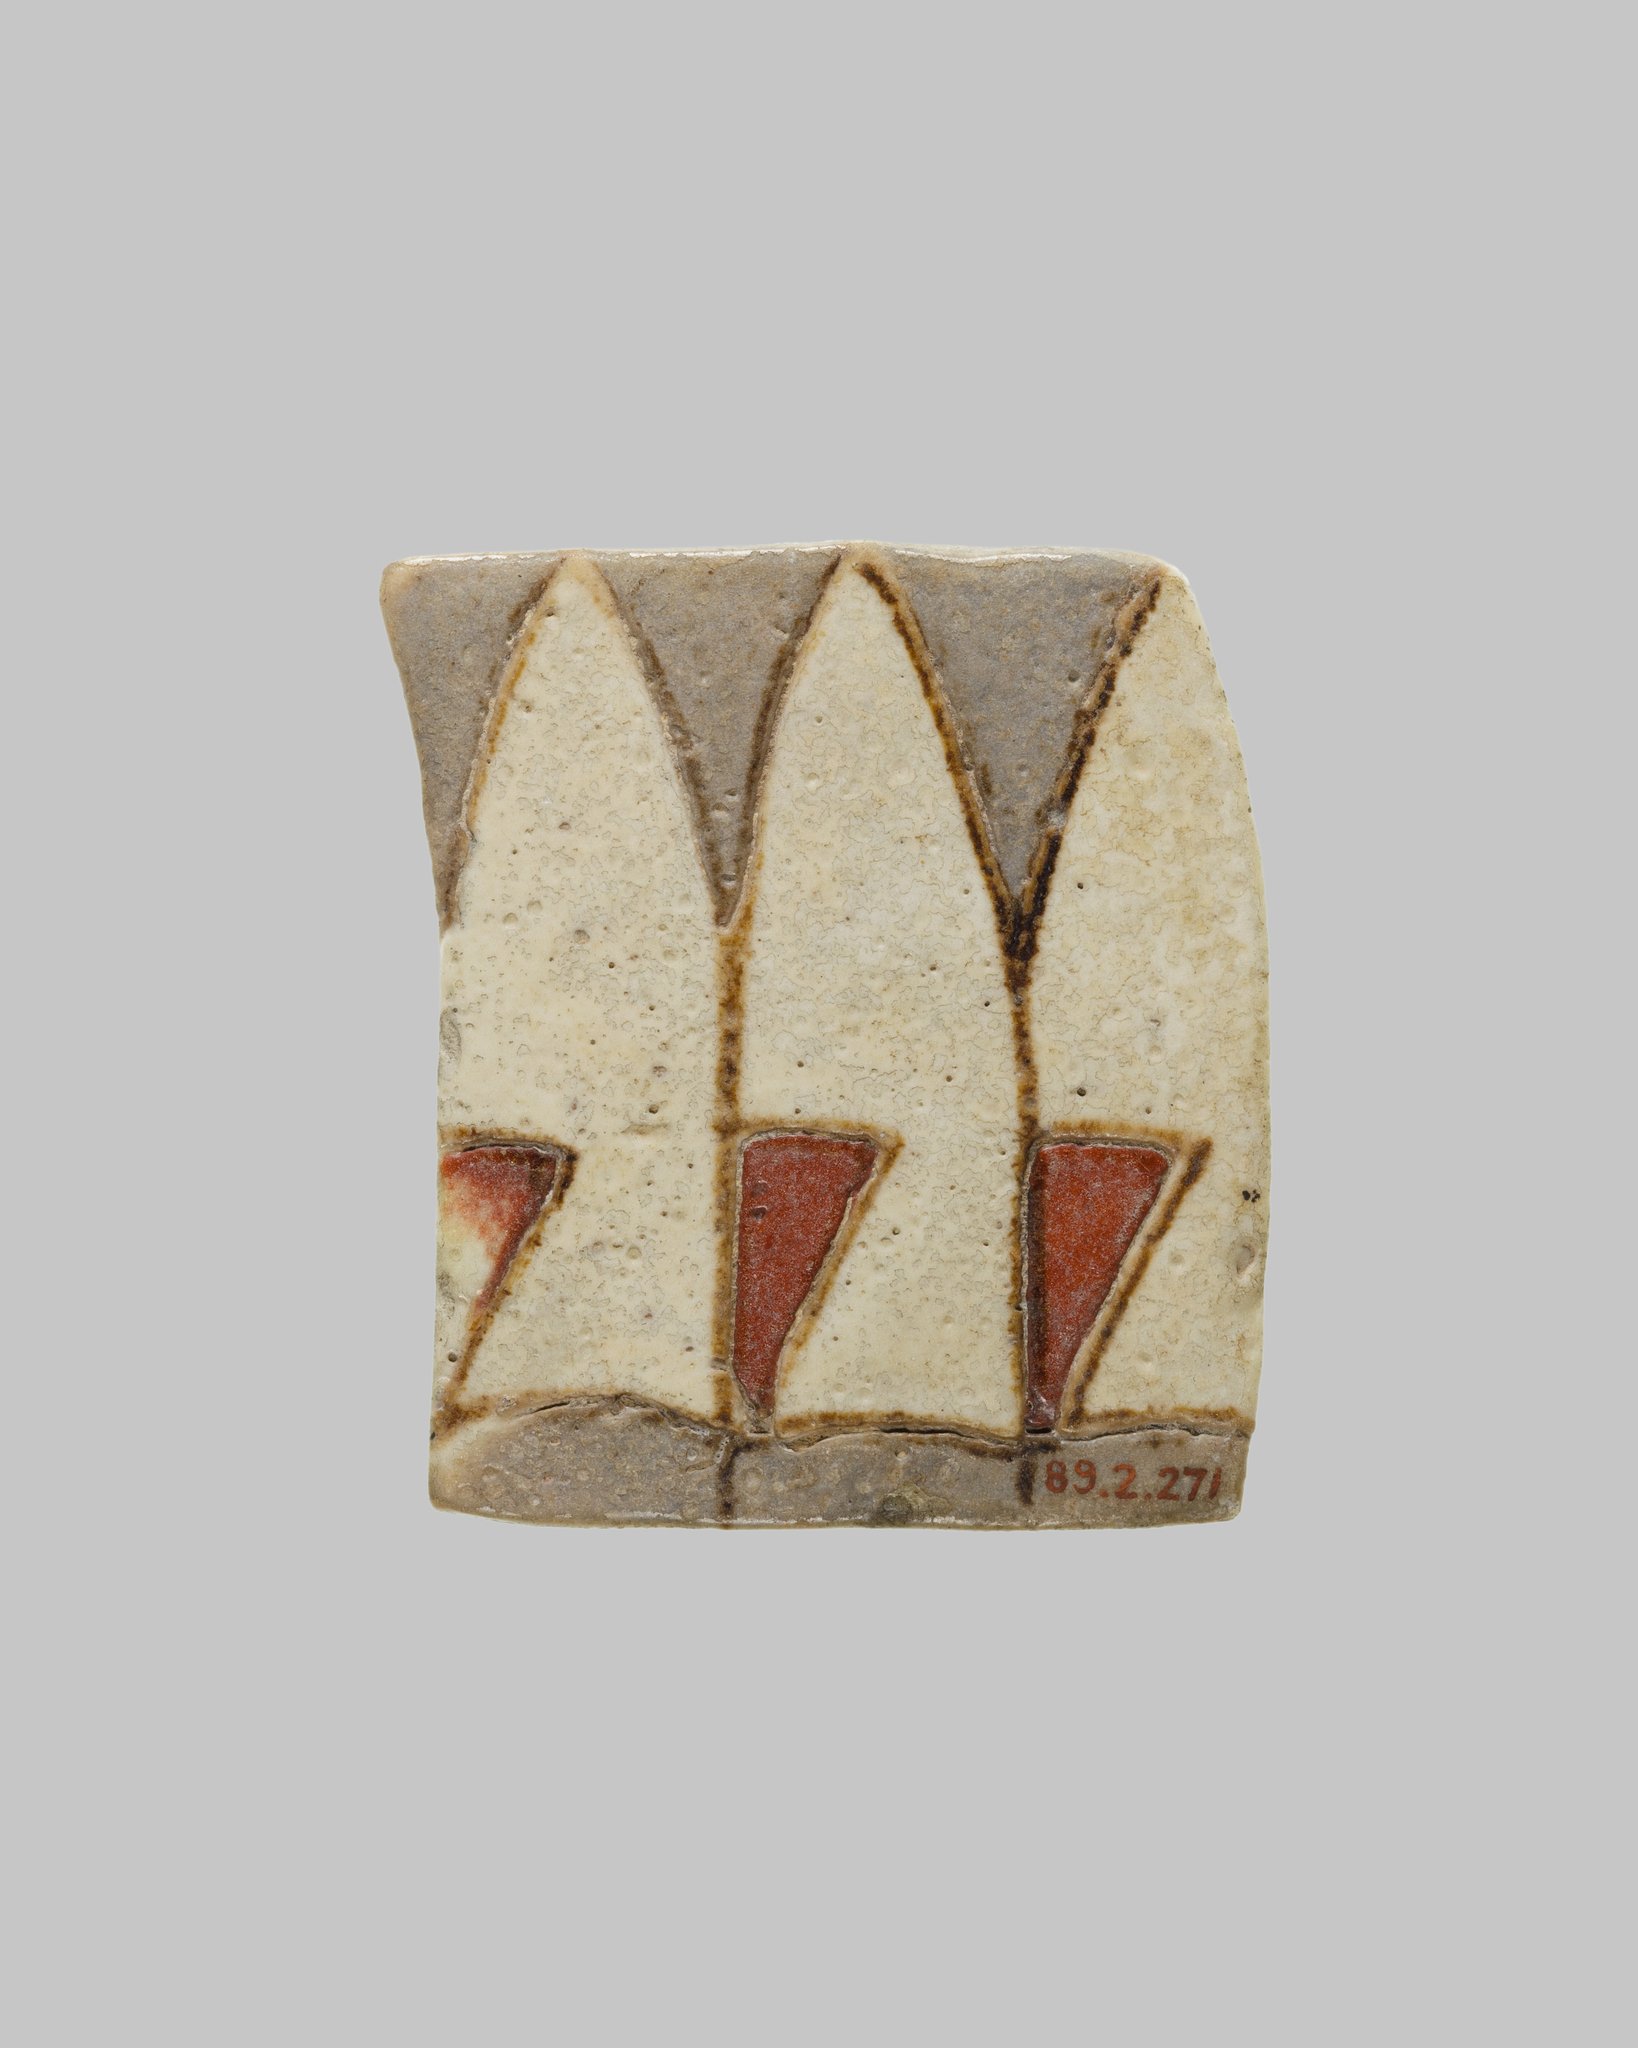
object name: inlay, lotus, lily, bud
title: Faience Inlay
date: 1184-1153 BCE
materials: faience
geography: egypt